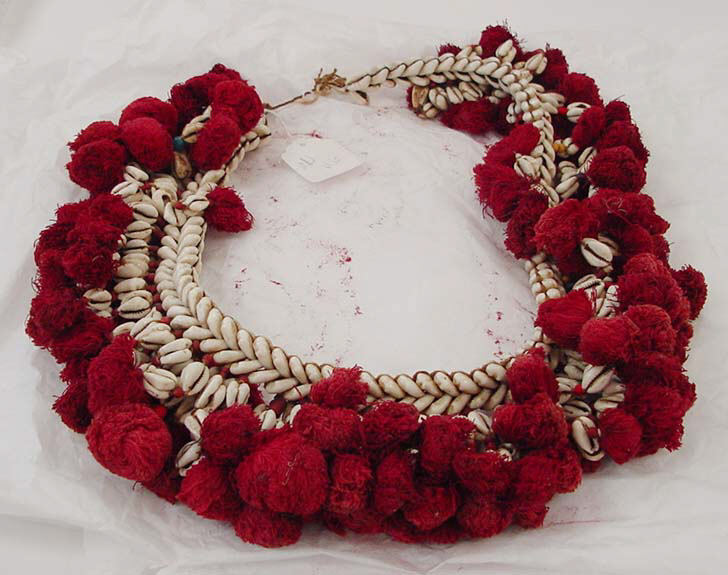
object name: belt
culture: oceanic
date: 1801-1900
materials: cotton, glass, shell